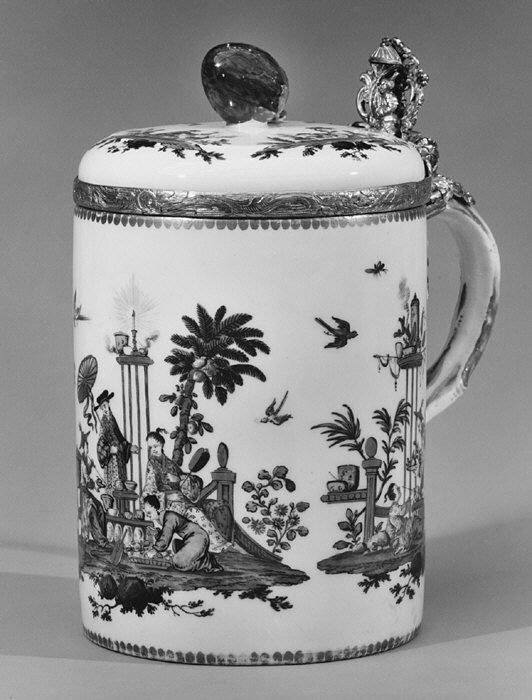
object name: tankard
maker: meissen manufactory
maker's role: manufactory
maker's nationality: german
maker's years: 1710-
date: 1740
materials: hard paste porcelain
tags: birds,men,women,trees